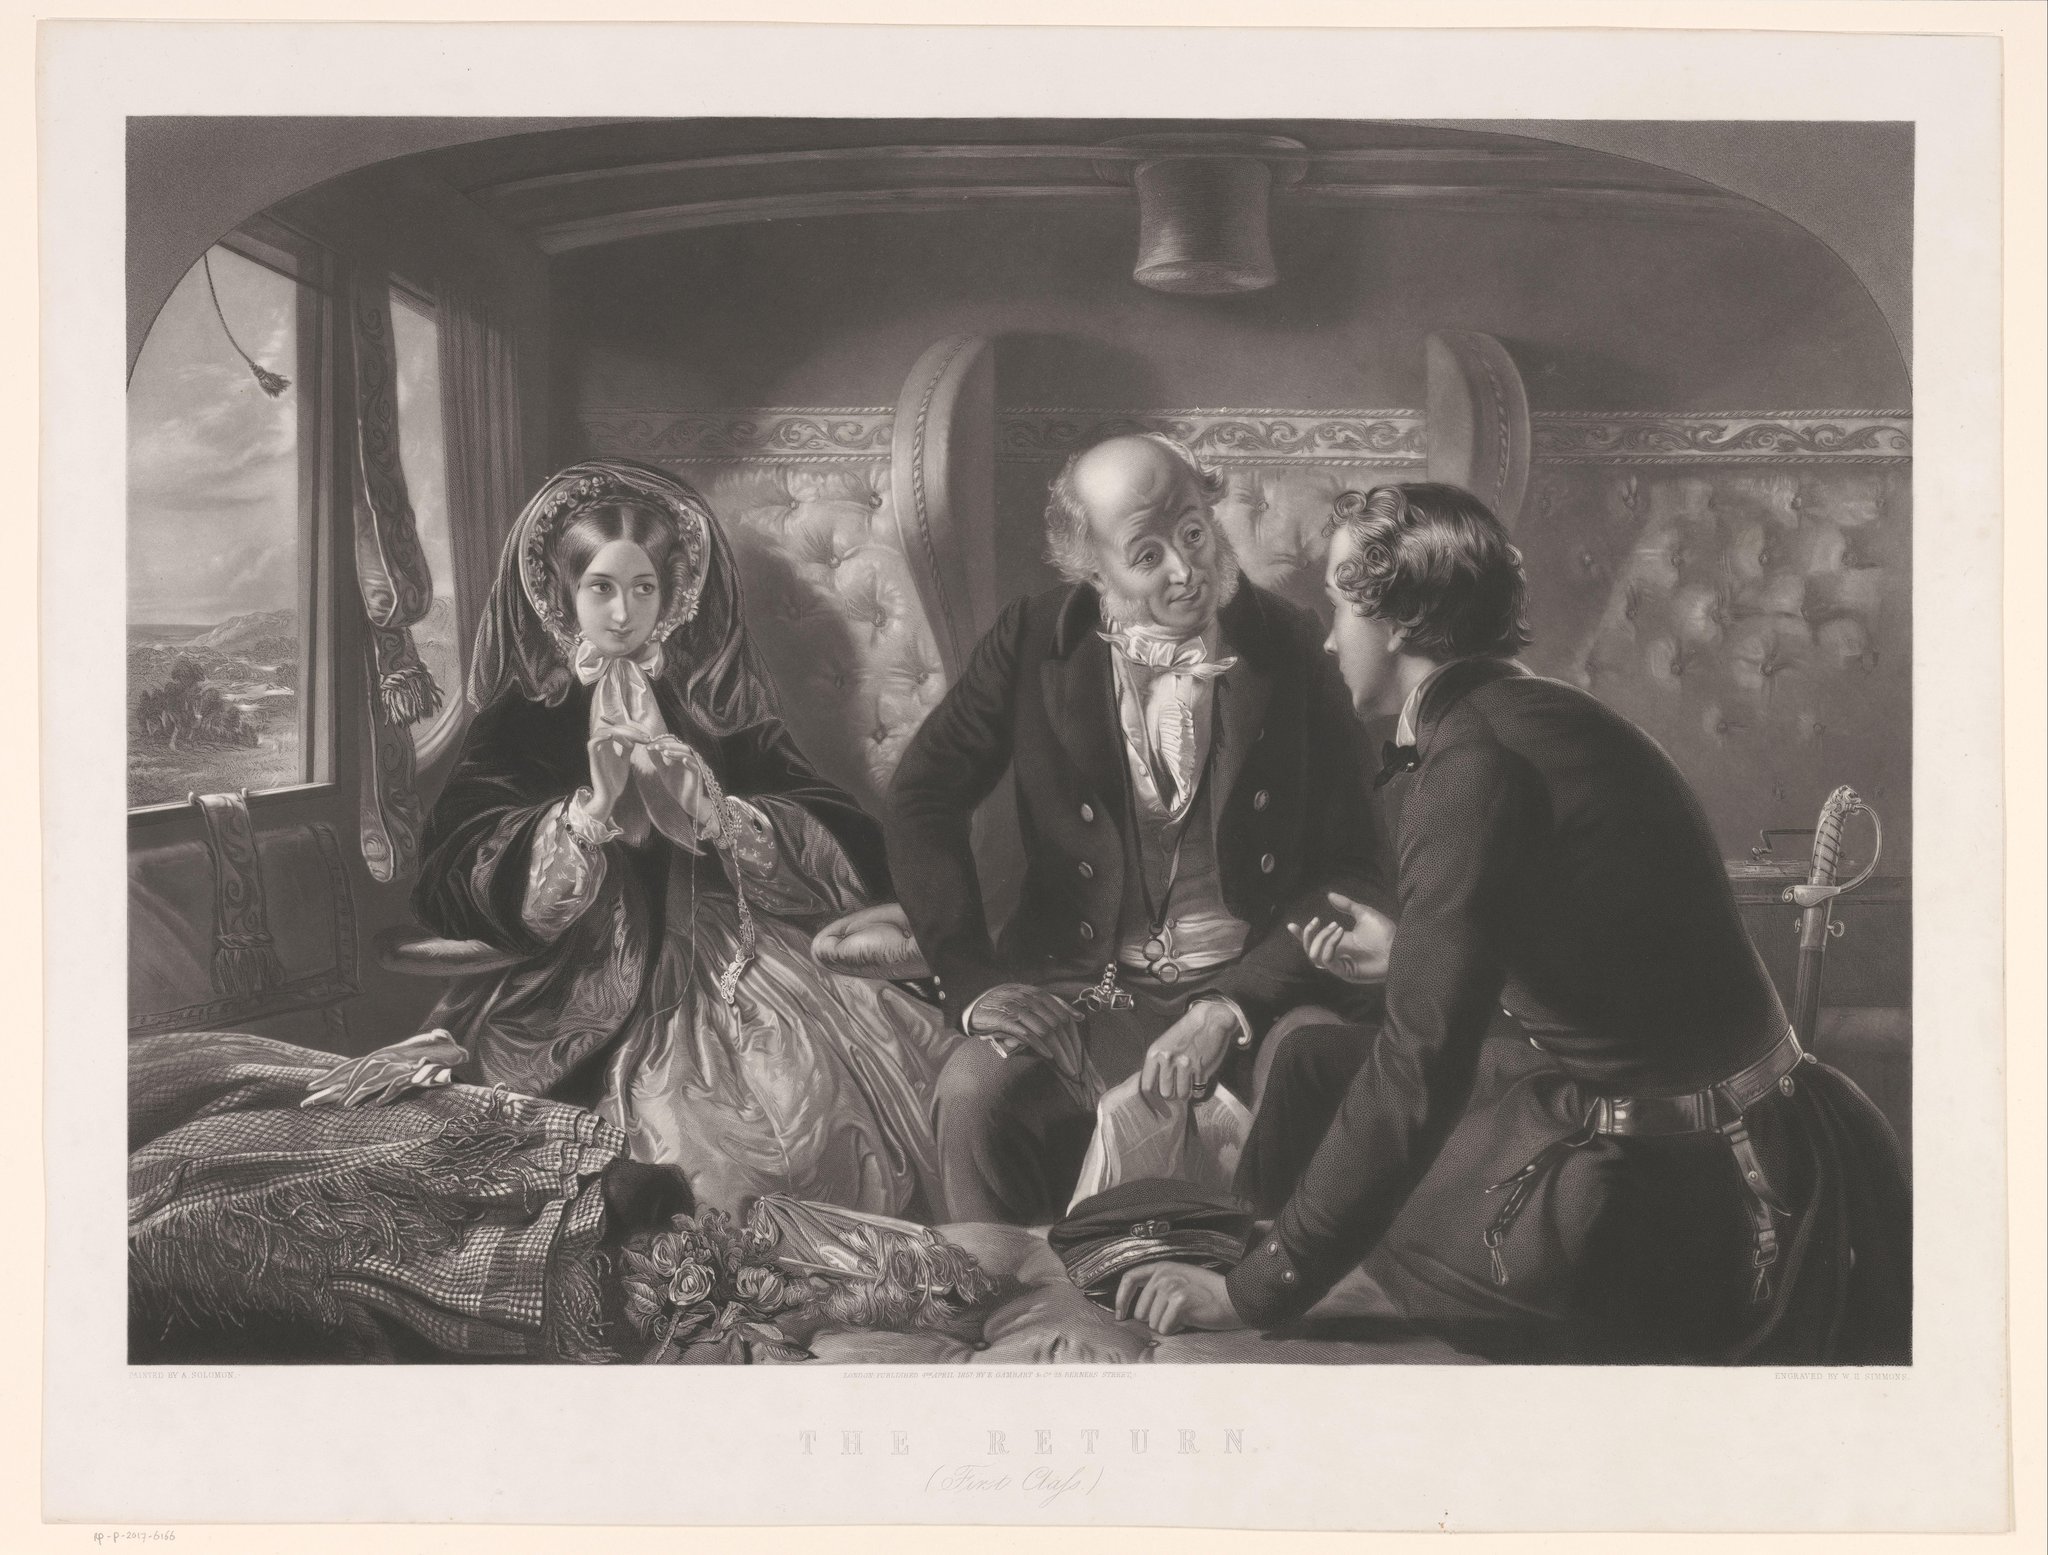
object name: print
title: Jongeman in uniform in gesprek met man en dochter in een treinwagon eerste klasse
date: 1804-1857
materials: paper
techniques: mezzotint, stippling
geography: london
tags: passenger train, lace-making, contrast between rich and poor, arrival and return ~ travelling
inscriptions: collector's mark: Lugt 2228